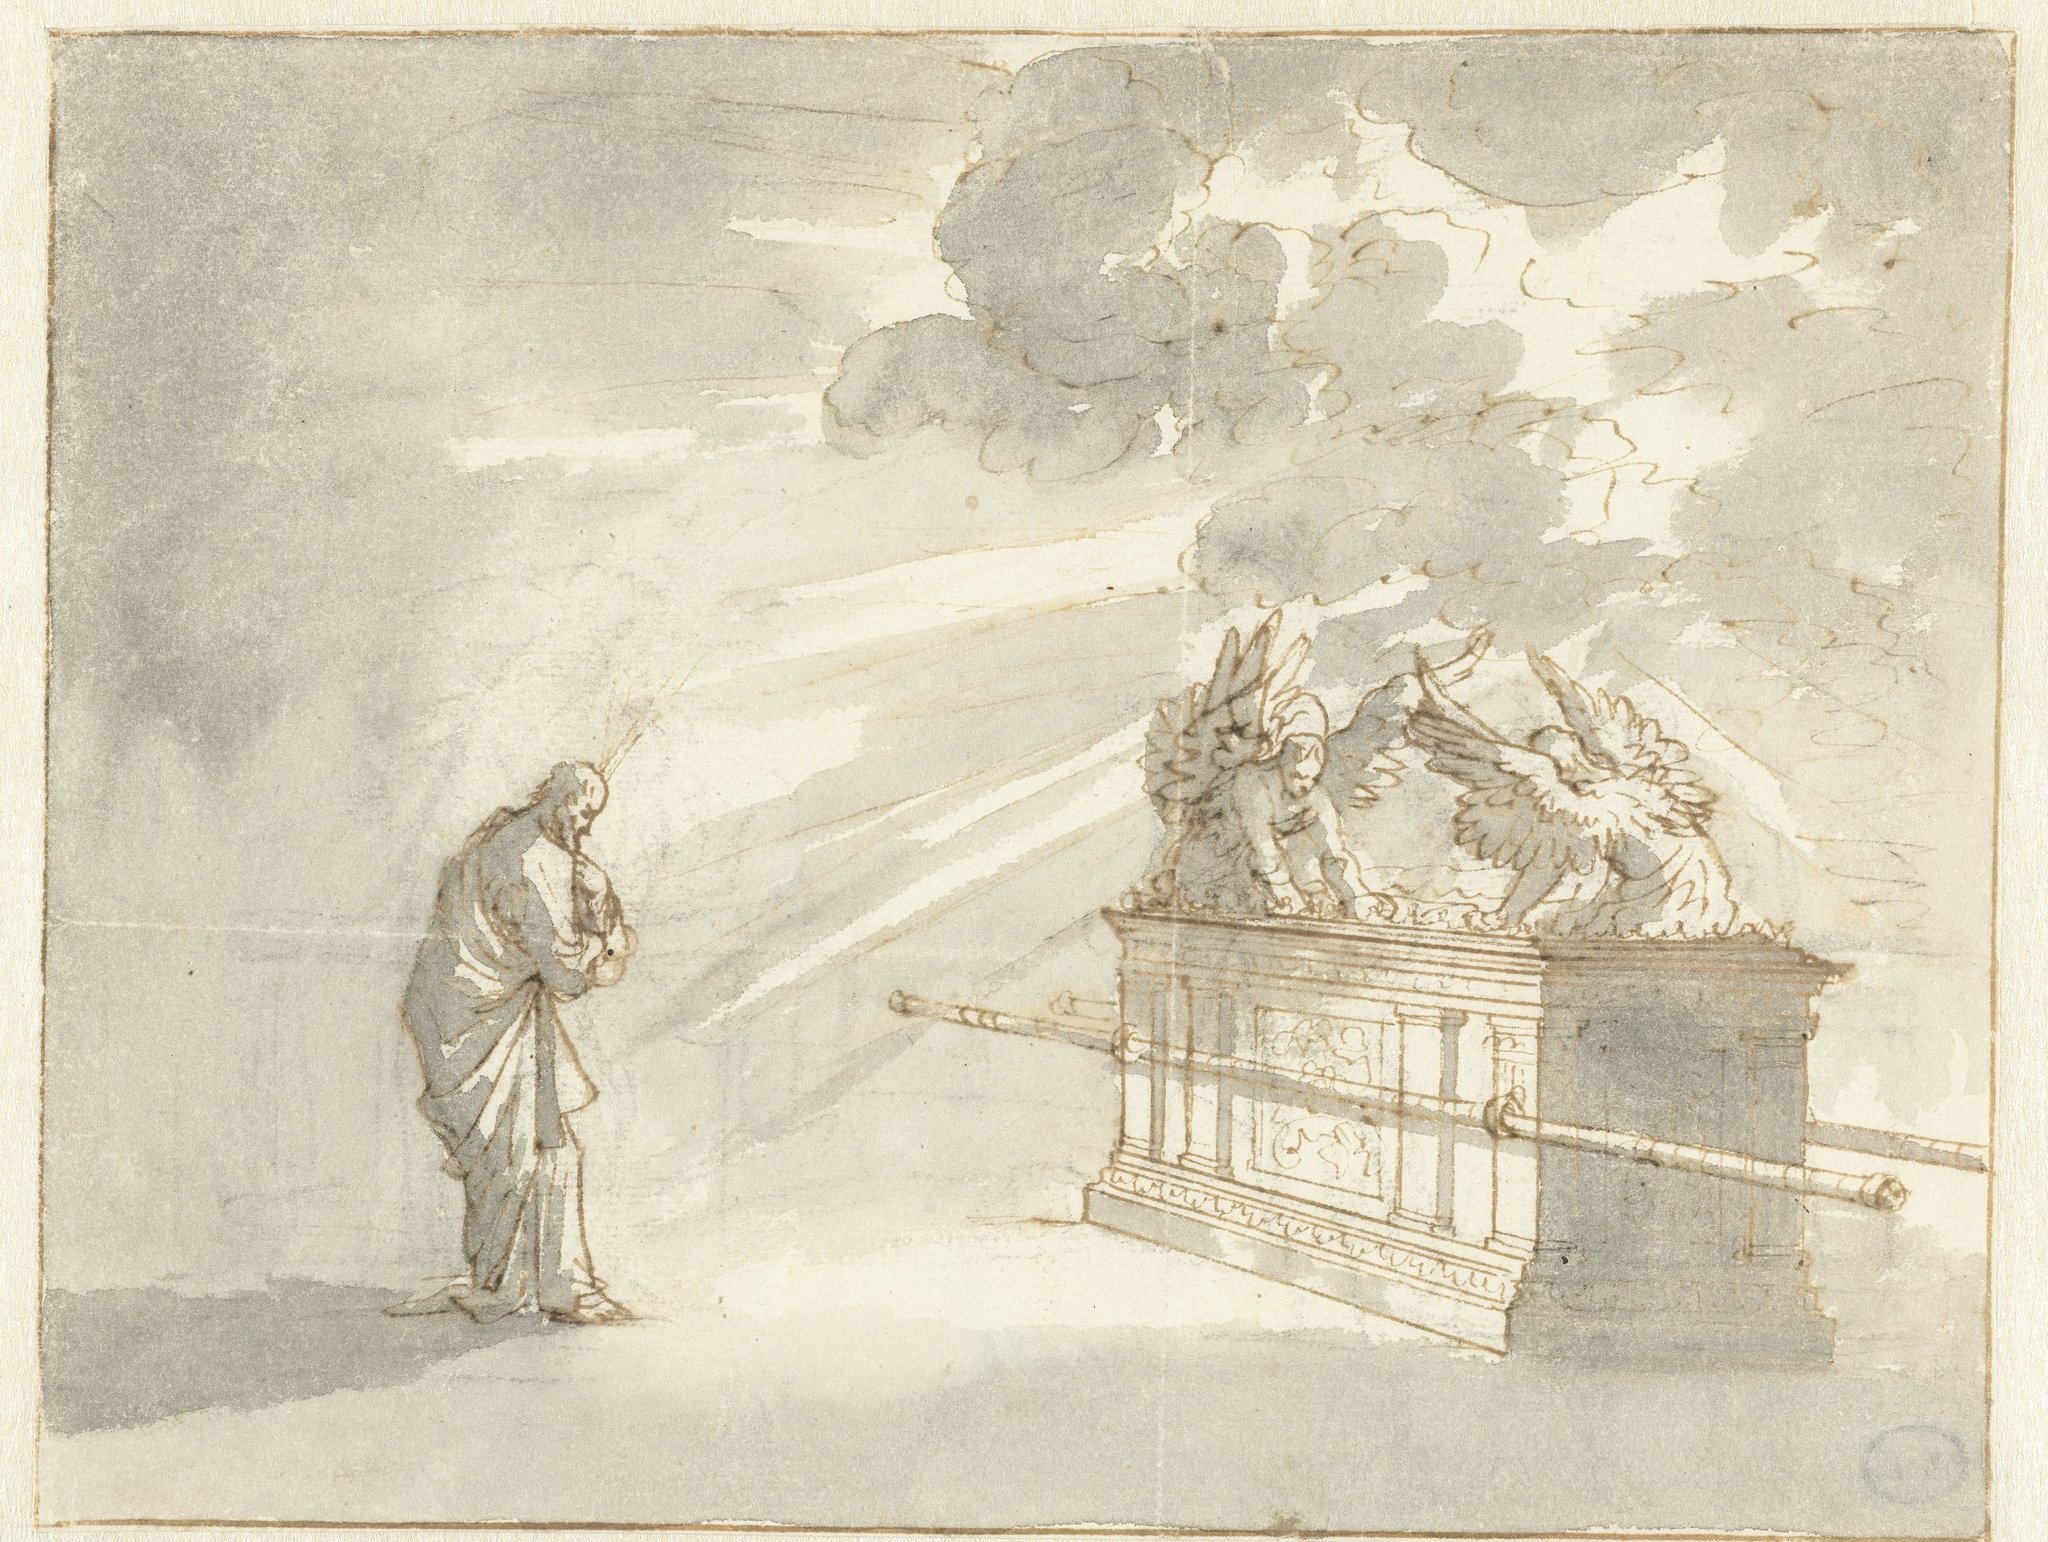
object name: design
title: Mozes staande bij de Ark des Verbonds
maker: jan luyken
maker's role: draughtsman, print maker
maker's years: 1649-1712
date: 1703-1705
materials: chalk, ink, paper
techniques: brush, pen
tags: moses communicating with god (in general), the tabernacle is set up and moses puts the ark with the tables in it